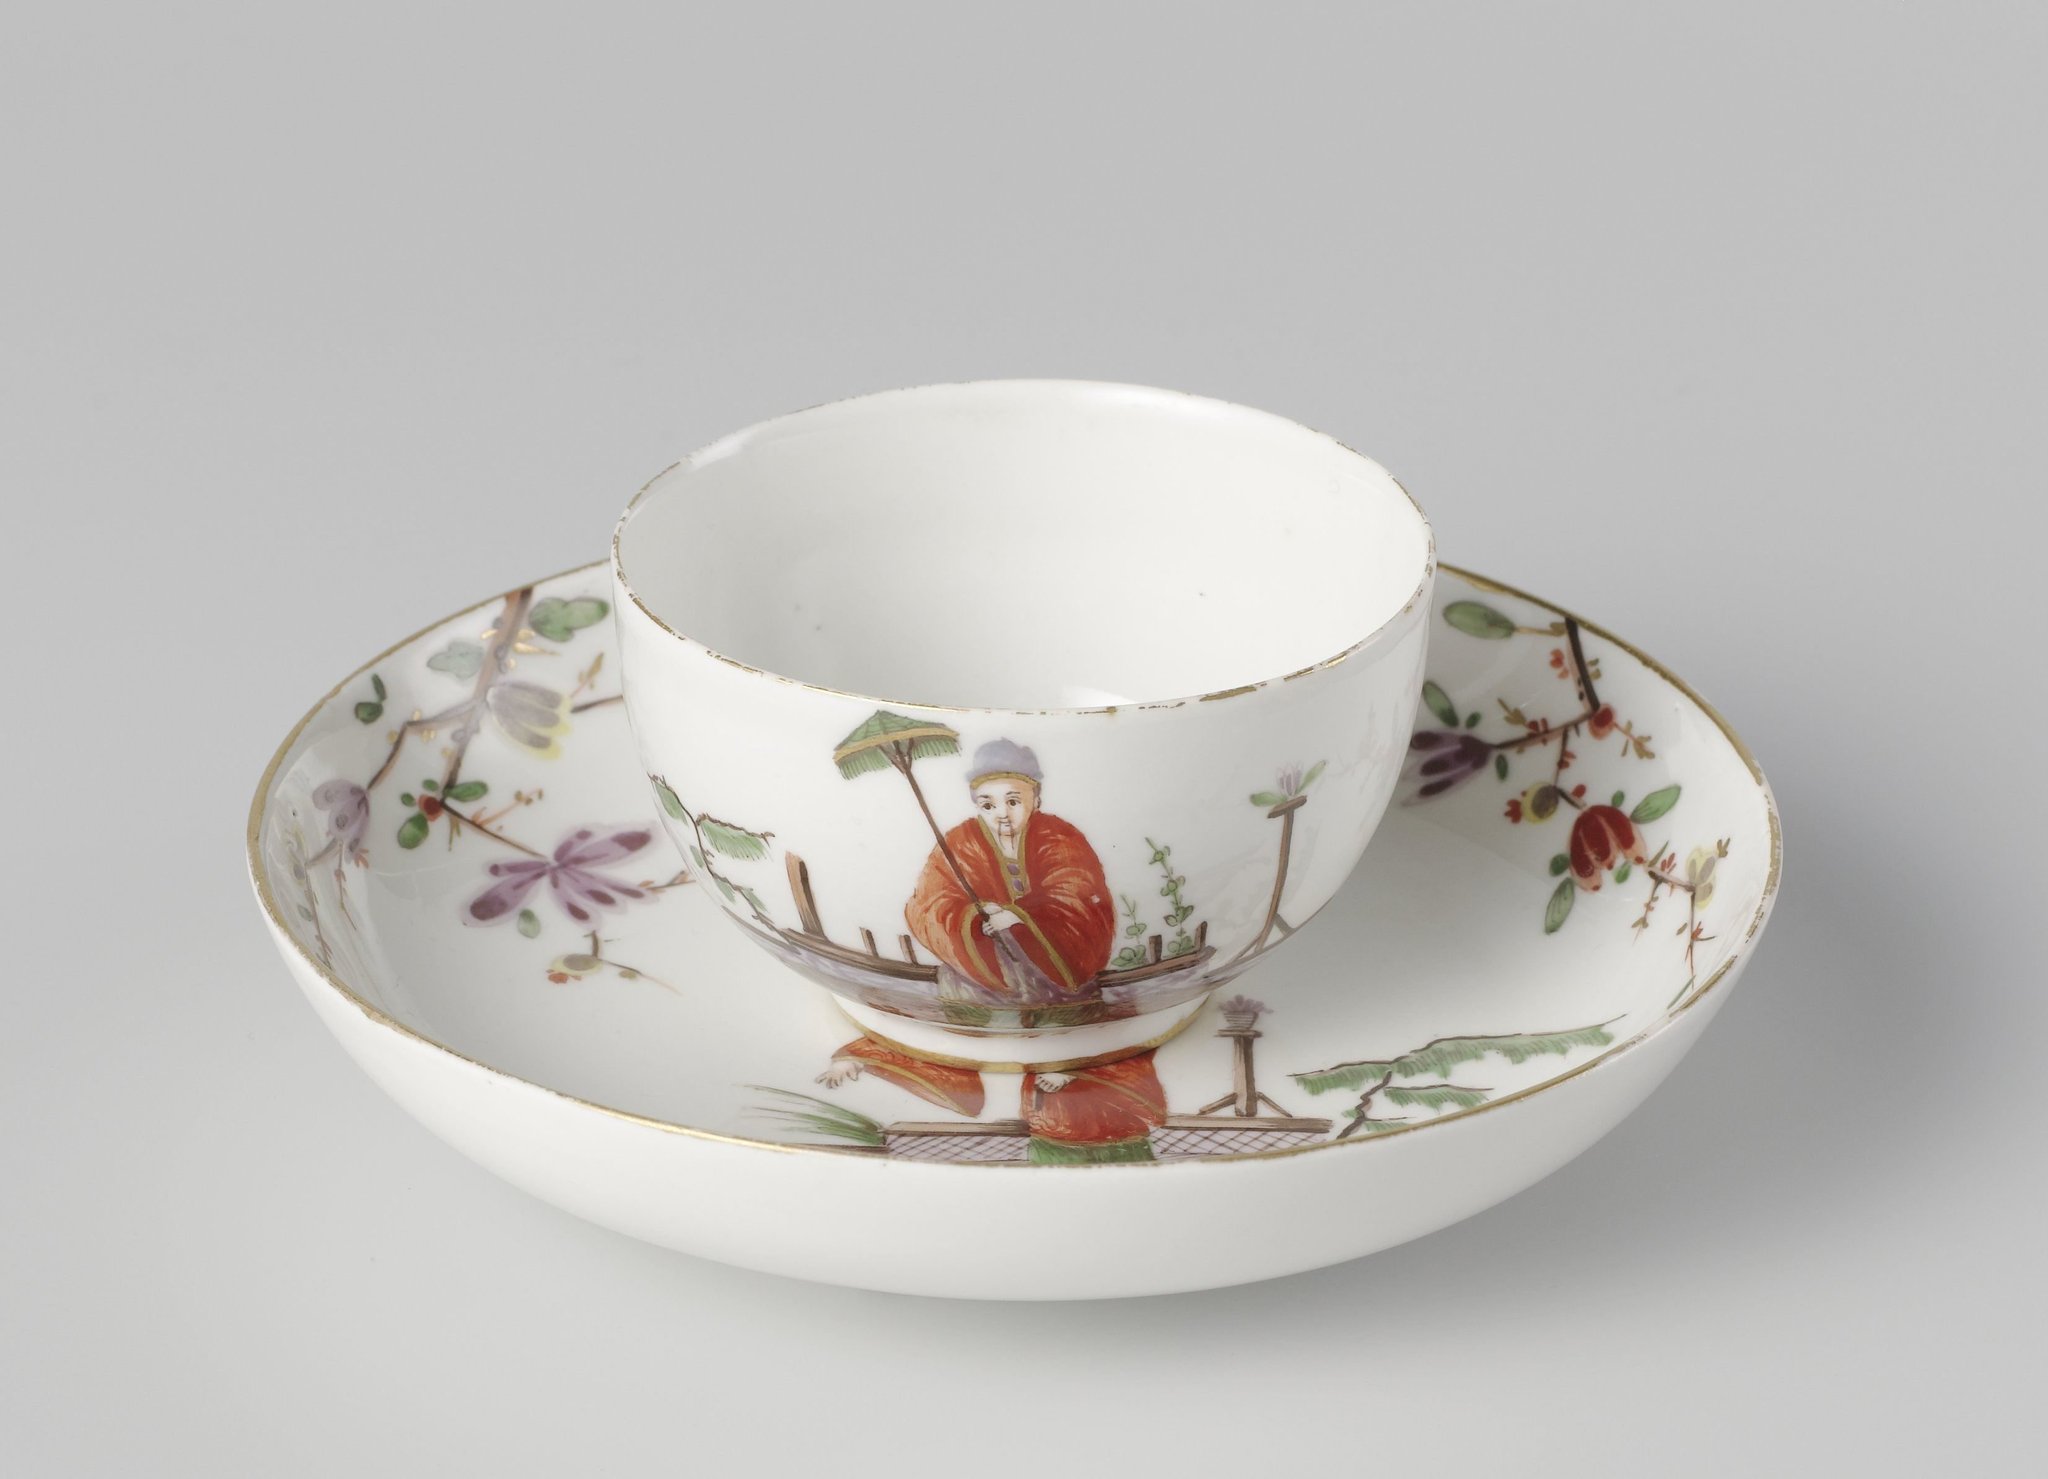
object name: kop en schotel, kop en schotel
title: Cup and saucer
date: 1765-1770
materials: porcelain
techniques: painted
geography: weesp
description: Weesper porseleinfabriek Weesp, c. 1765–1770 hard-paste porcelain